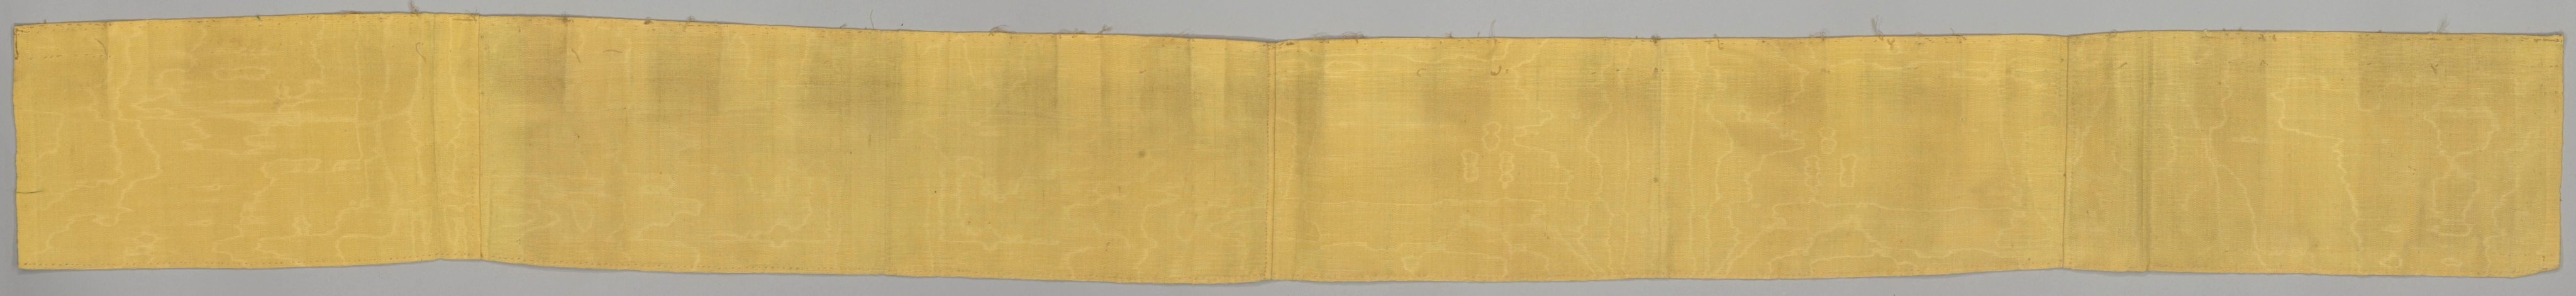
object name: fragment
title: Fragment van een bedgarnituur van gele gewaterde wol met groen passement en afhangende klosjes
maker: Anonymous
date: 1795-1815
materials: wool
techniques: moire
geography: northern netherlands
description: Fragment van een bedgarnituur van gele gewaterde wol, omboord met groen passement met een geel motief en met een groen en geel boordsel met afhangende klosjes die met gele en groene zijde zijn omwonden.